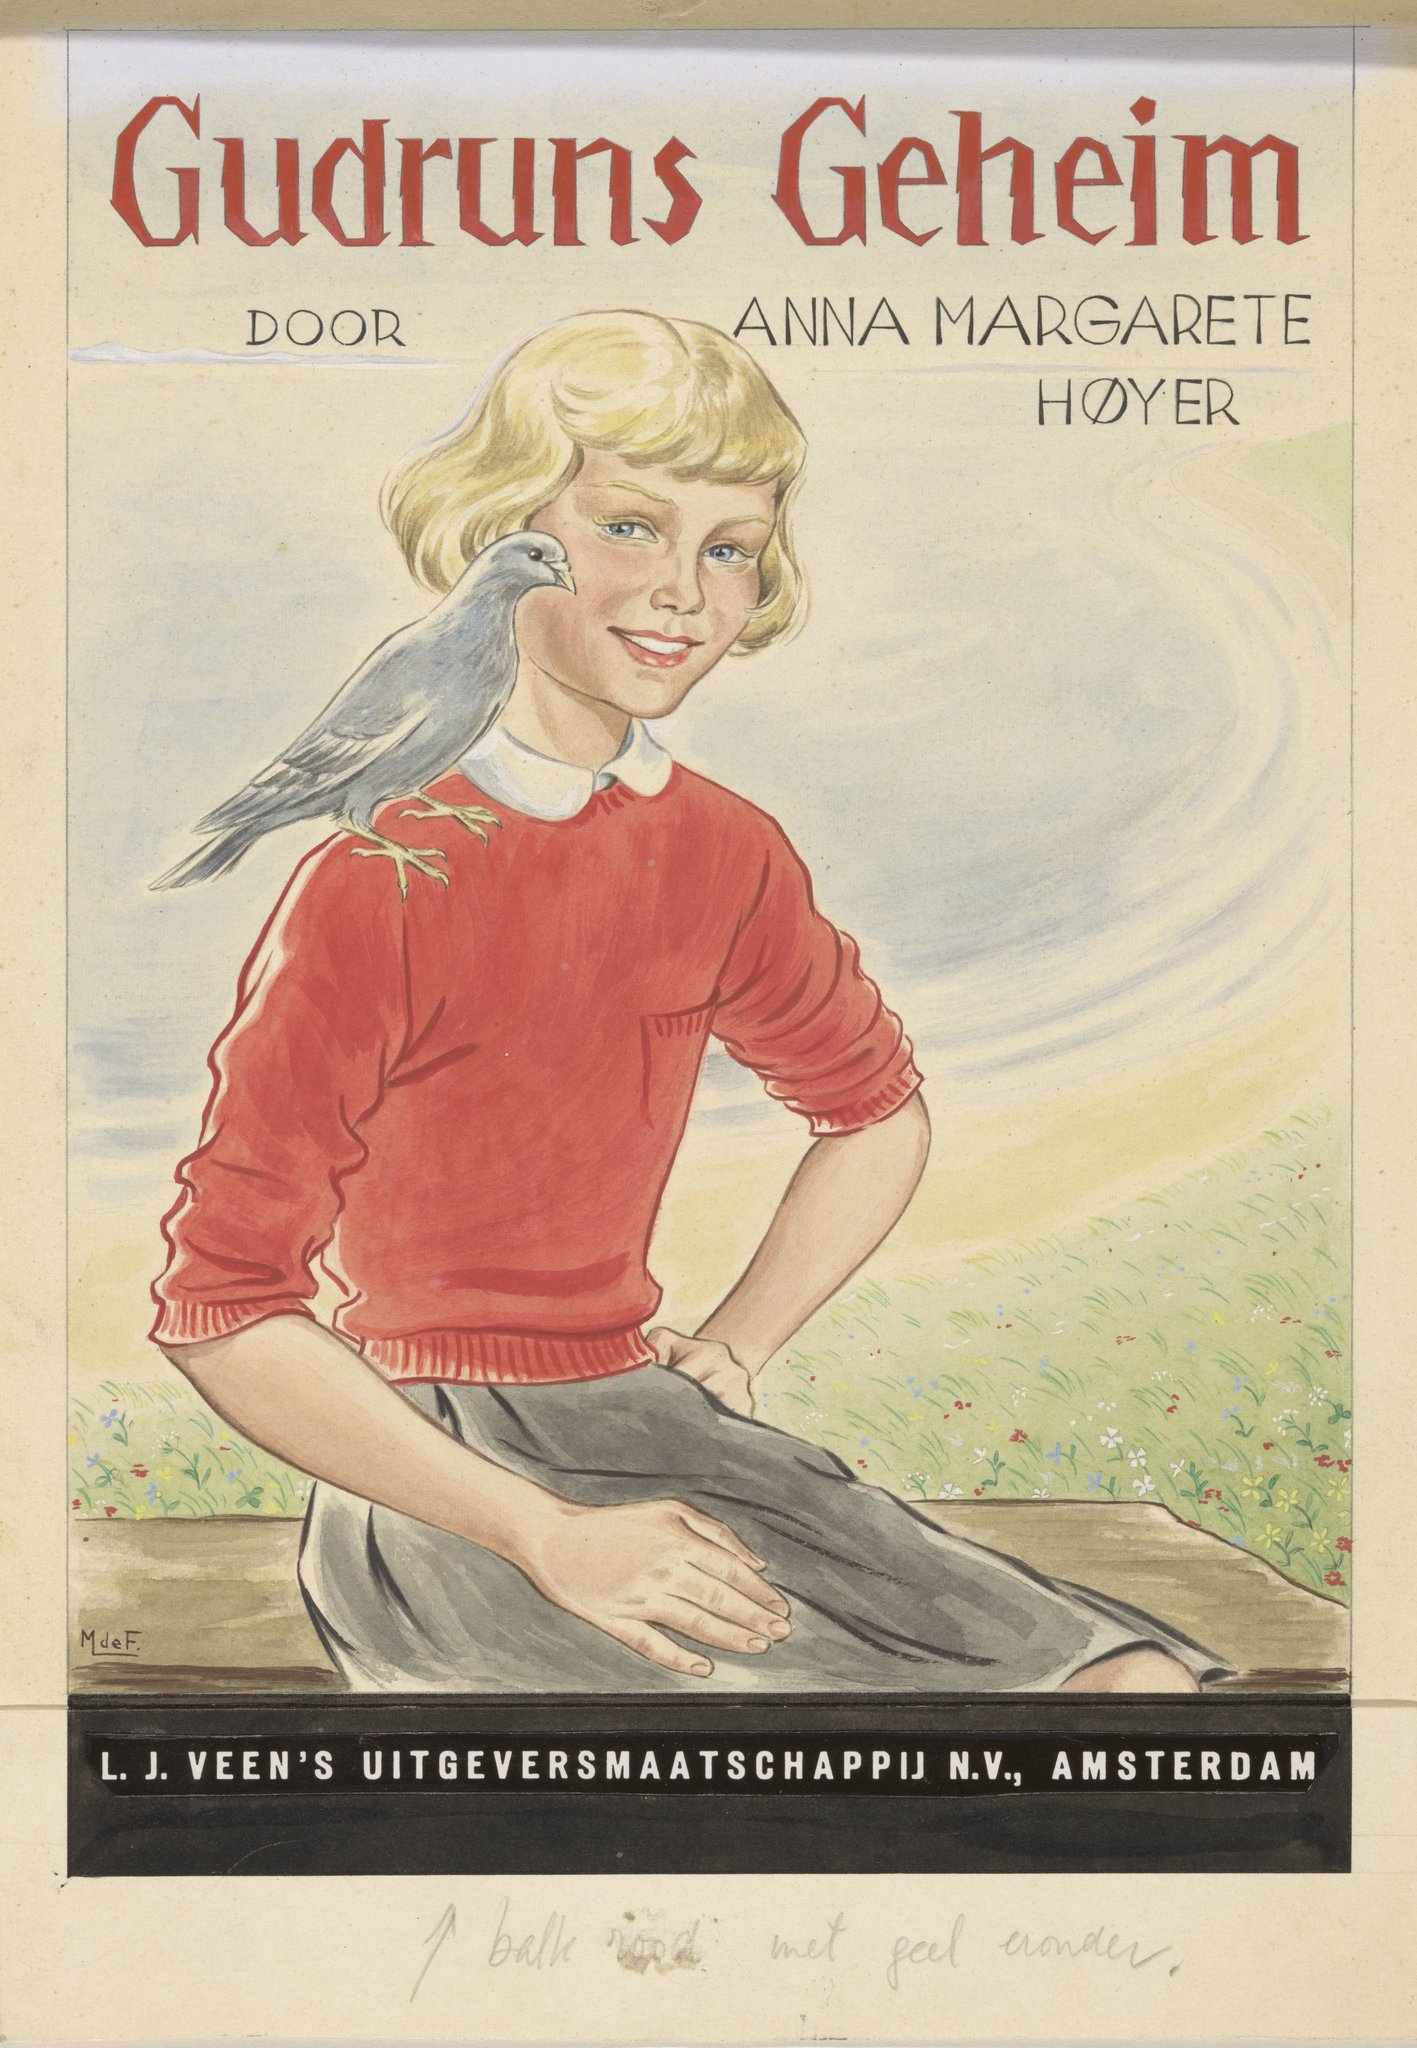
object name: drawing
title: Bandontwerp voor: Anna Margarete Hoyer, Gudruns geheim, 1953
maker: miep de feijter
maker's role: draughtsman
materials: paint, ink, paper, pencil, watercolor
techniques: brush, pen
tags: bench, sitting figure - aa - female human figure, girl (child between toddler and youth), doves, pigeons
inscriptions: signature: ‘M de F.’, collector's mark: Lugt 2228a, :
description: Een glimlachend meisje zit in de open lucht op een bank. Op haar schouder zit een duif.